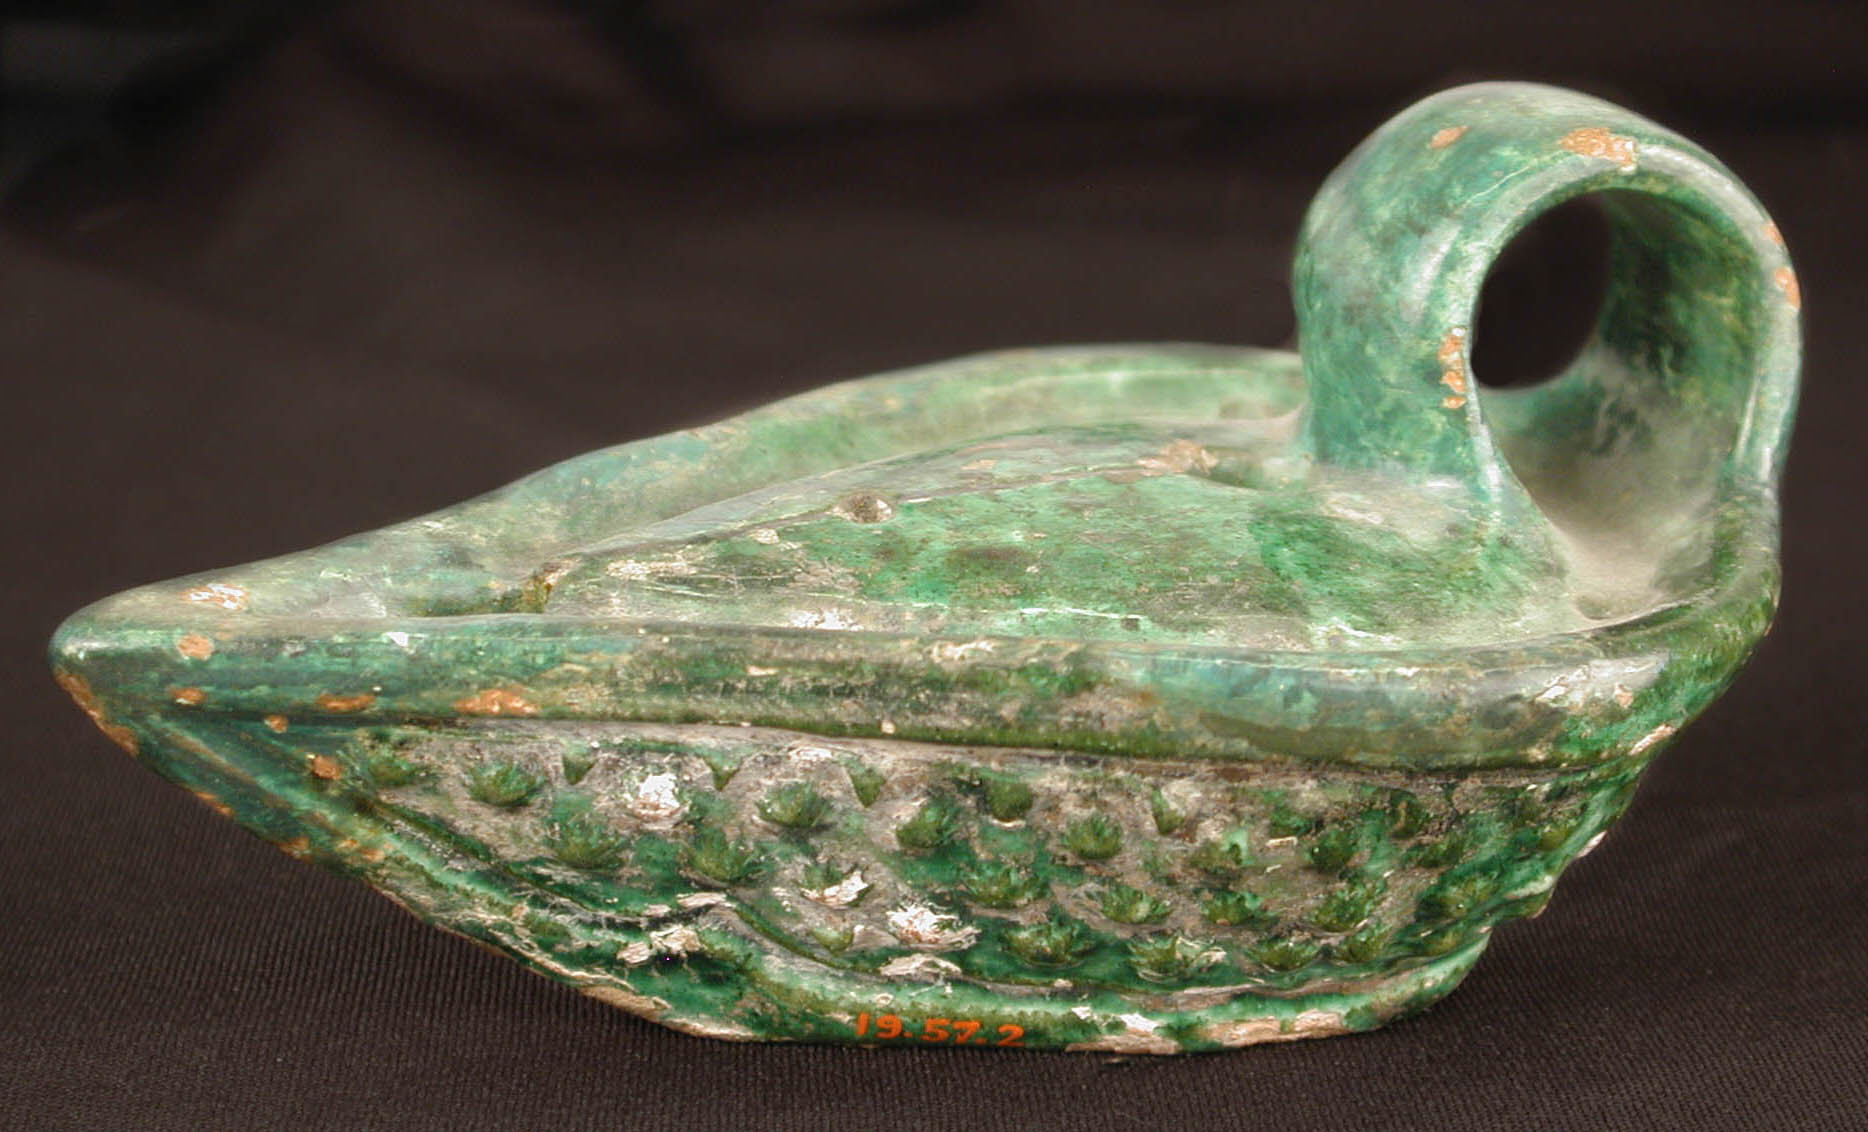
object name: lamp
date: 801-900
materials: earthenware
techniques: glazing, molding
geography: syria